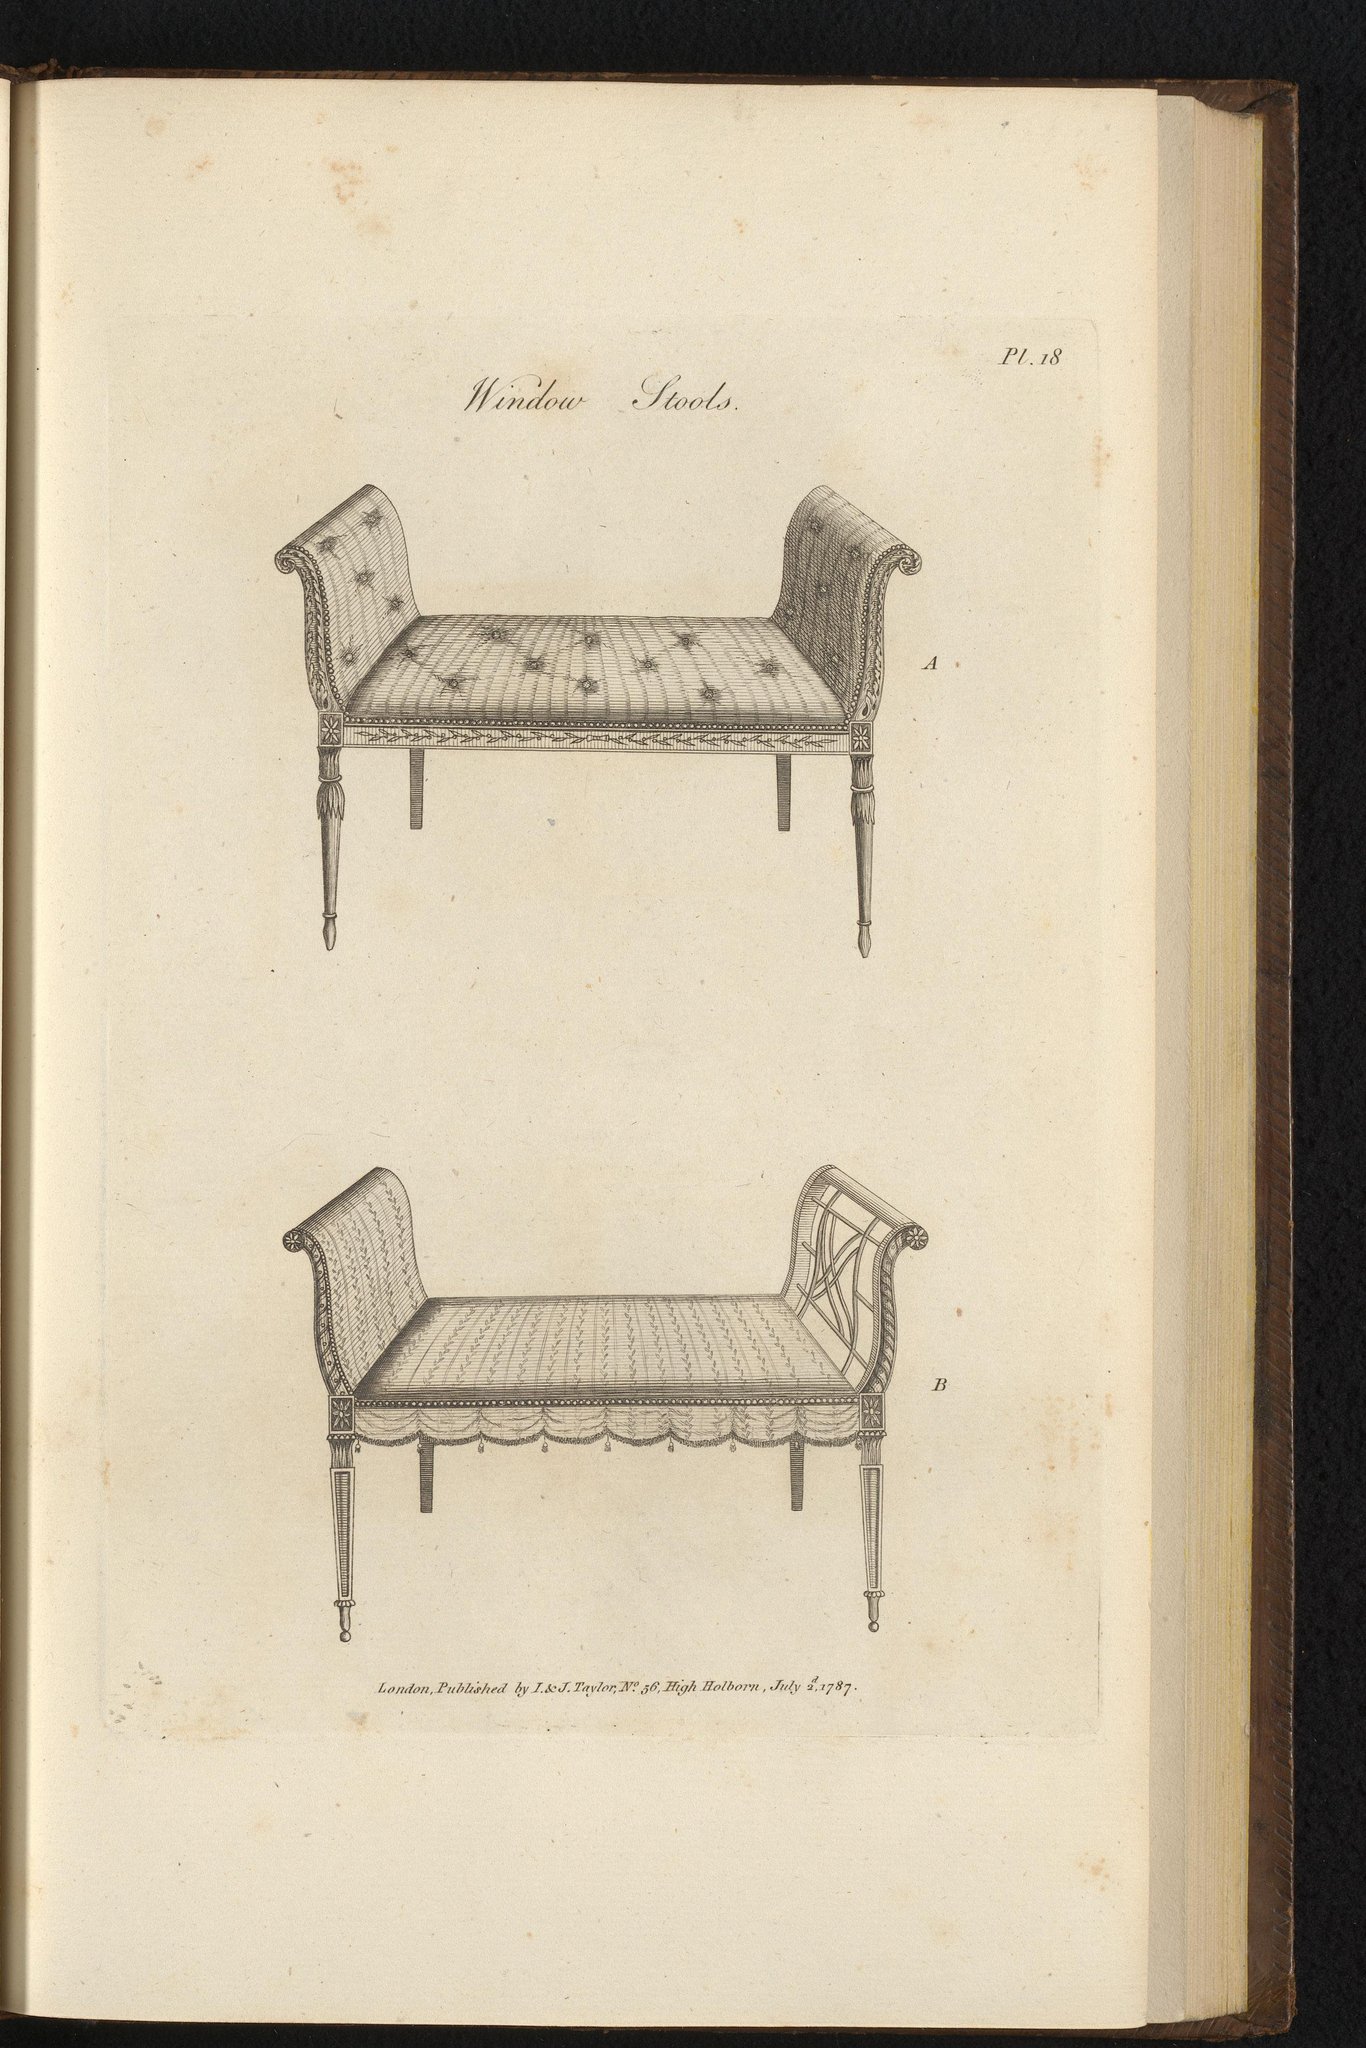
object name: print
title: Meubels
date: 1787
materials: paper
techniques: engraving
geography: holborn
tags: chair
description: Genummerd: Pl. 18. krukken gemerkt: A en B. Prent maakt deel uit van een boek.